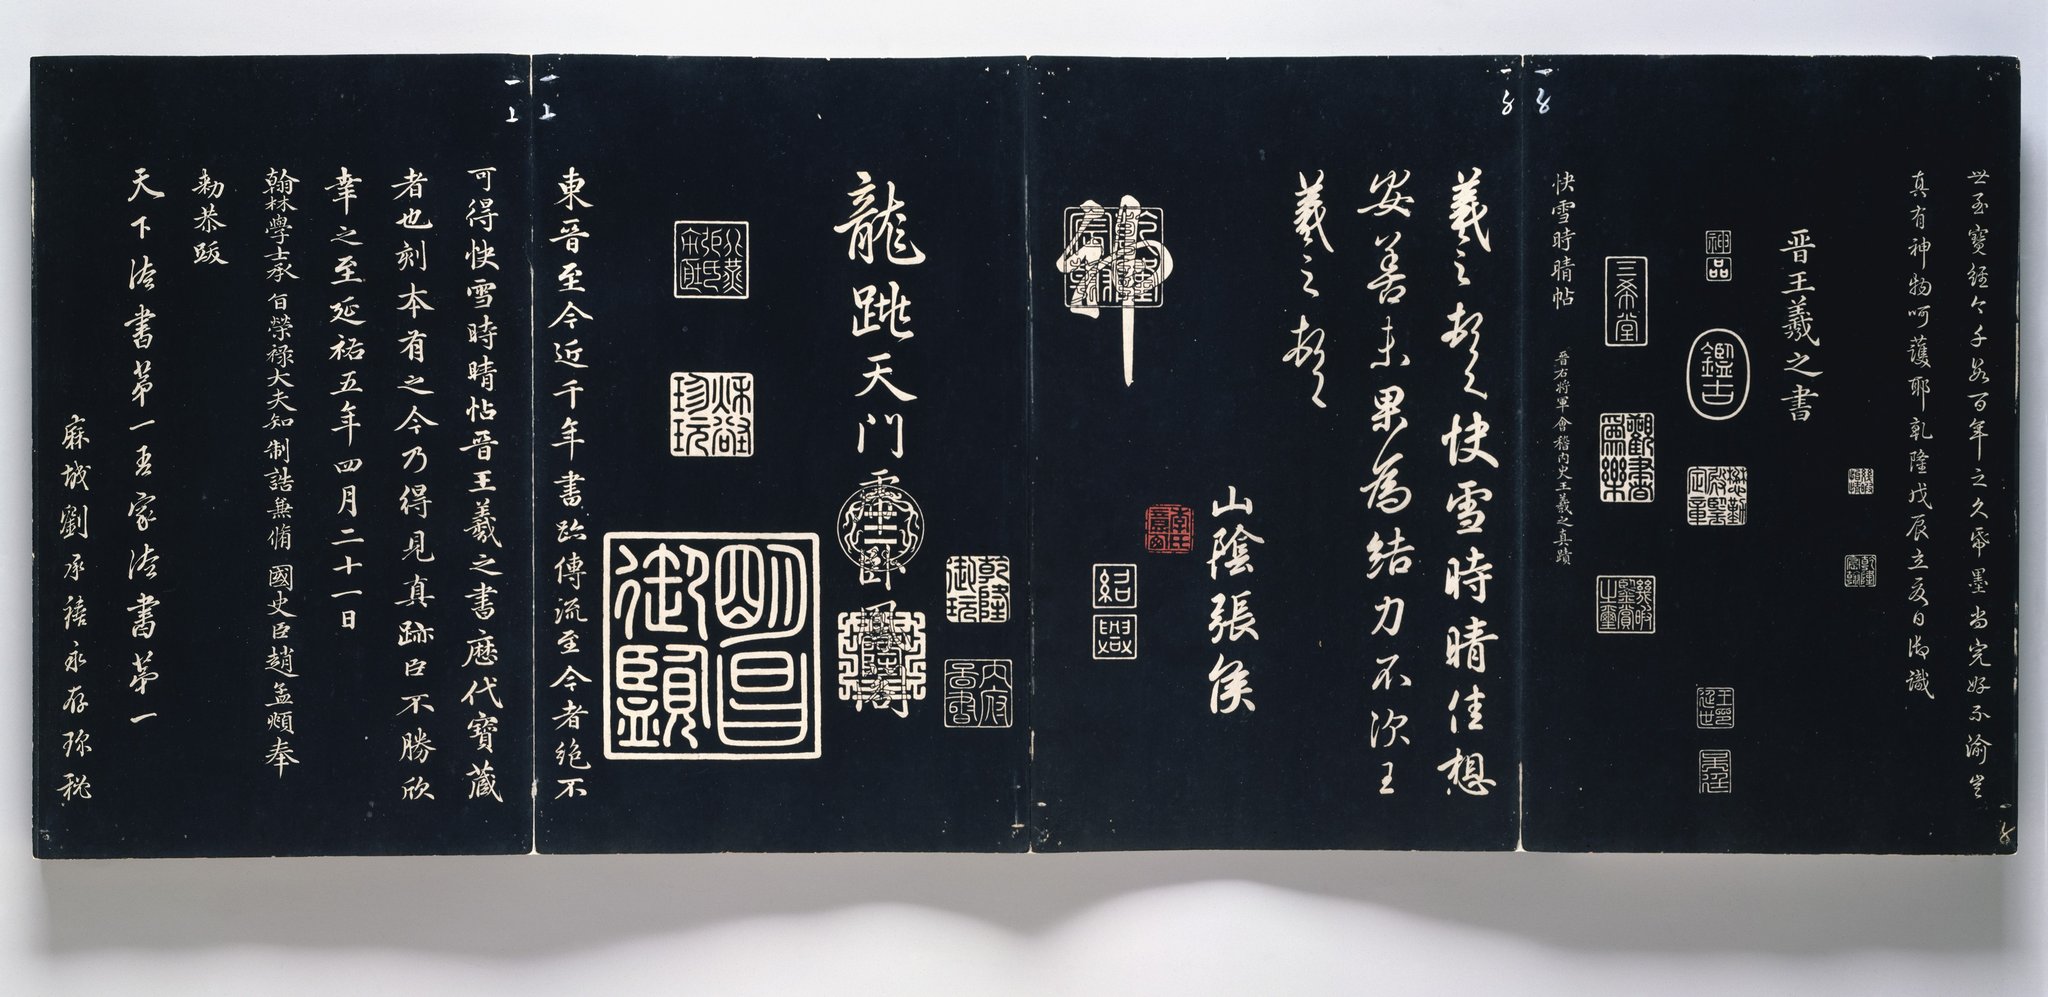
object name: calligraphy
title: Model Calligraphies from the “Hall of Three Rarities” (Sanxitang) and the "Collected Treasures of the Stony Moat” (Shiqu Baoji)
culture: chinese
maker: various artists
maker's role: artist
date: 1751-1800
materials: ink, paper